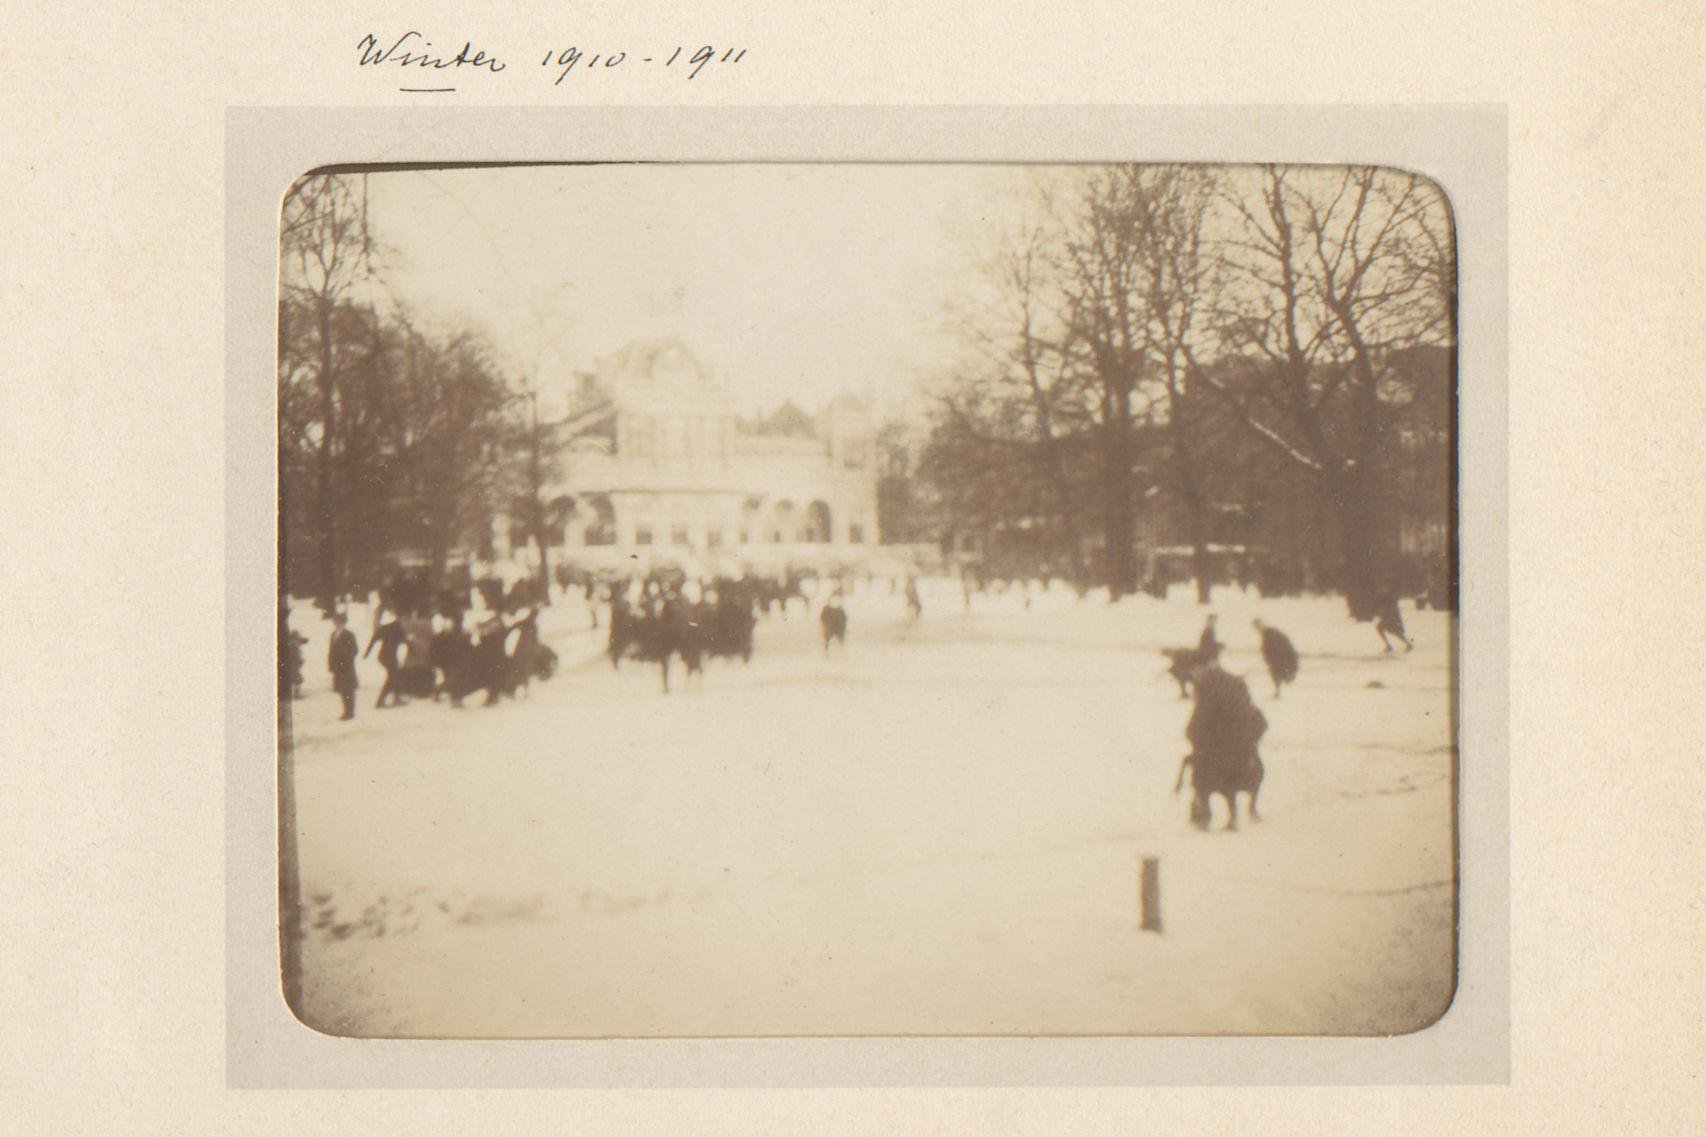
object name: album leaf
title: Menigte in de sneeuw op een bevroren vijver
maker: liesbeth overhoff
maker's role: fotograaf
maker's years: 1895-1969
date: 1910-1911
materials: paper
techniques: gelatin silver print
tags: lake, skates (winter sports)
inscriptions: inscription: ‘Winter 1910-1911’